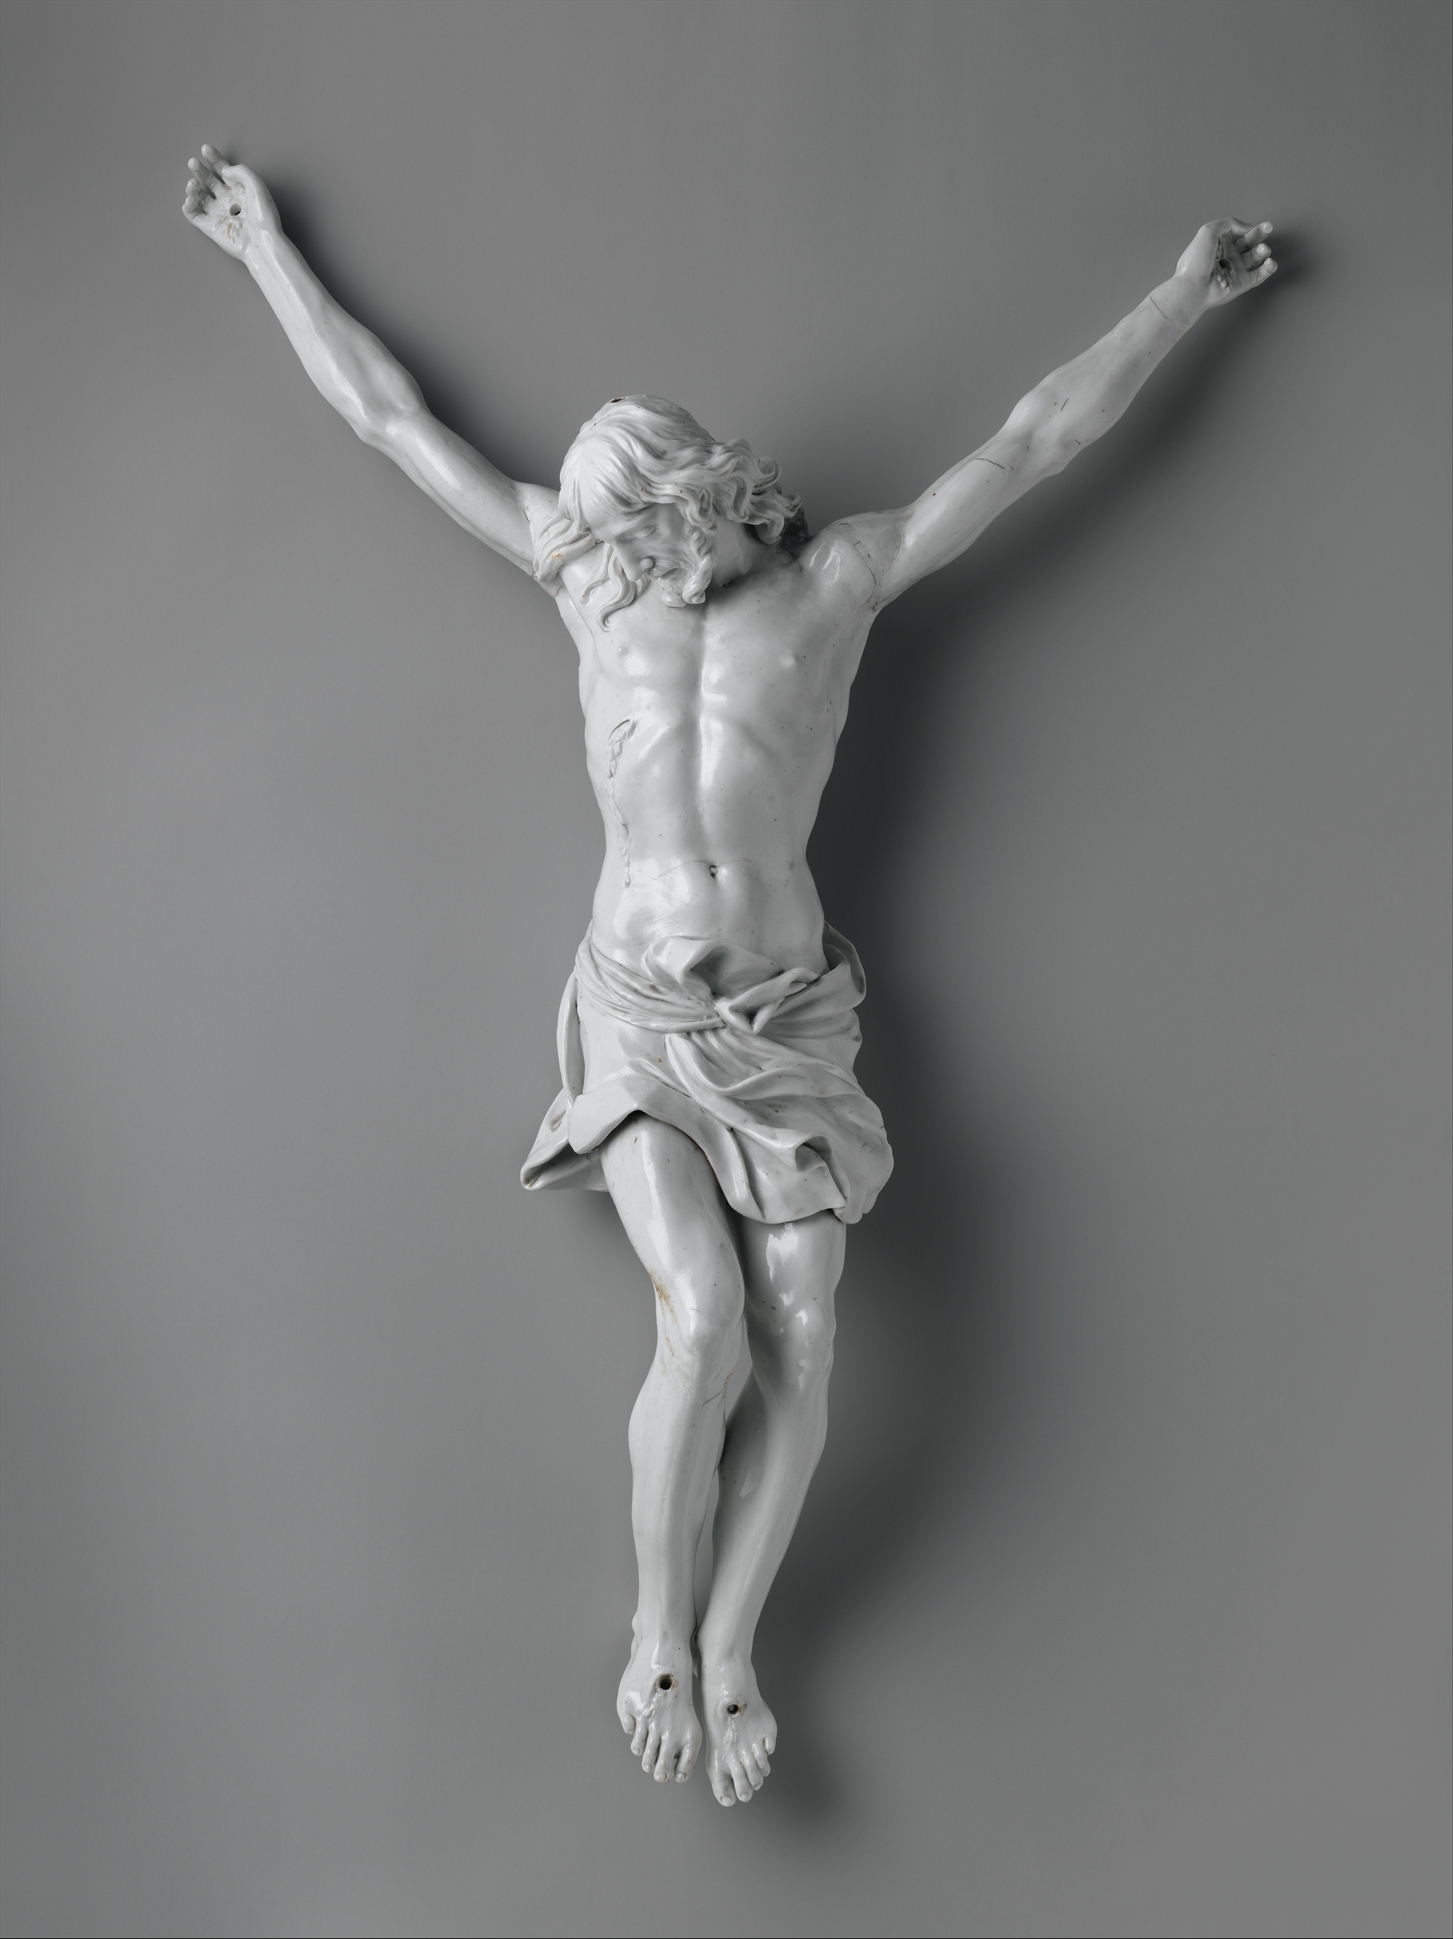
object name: figure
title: Corpus from a crucifix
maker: doccia porcelain manufactory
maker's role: manufactory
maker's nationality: italian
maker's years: 1737-1896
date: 1745-1750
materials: hard paste porcelain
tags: christ,crucifixion